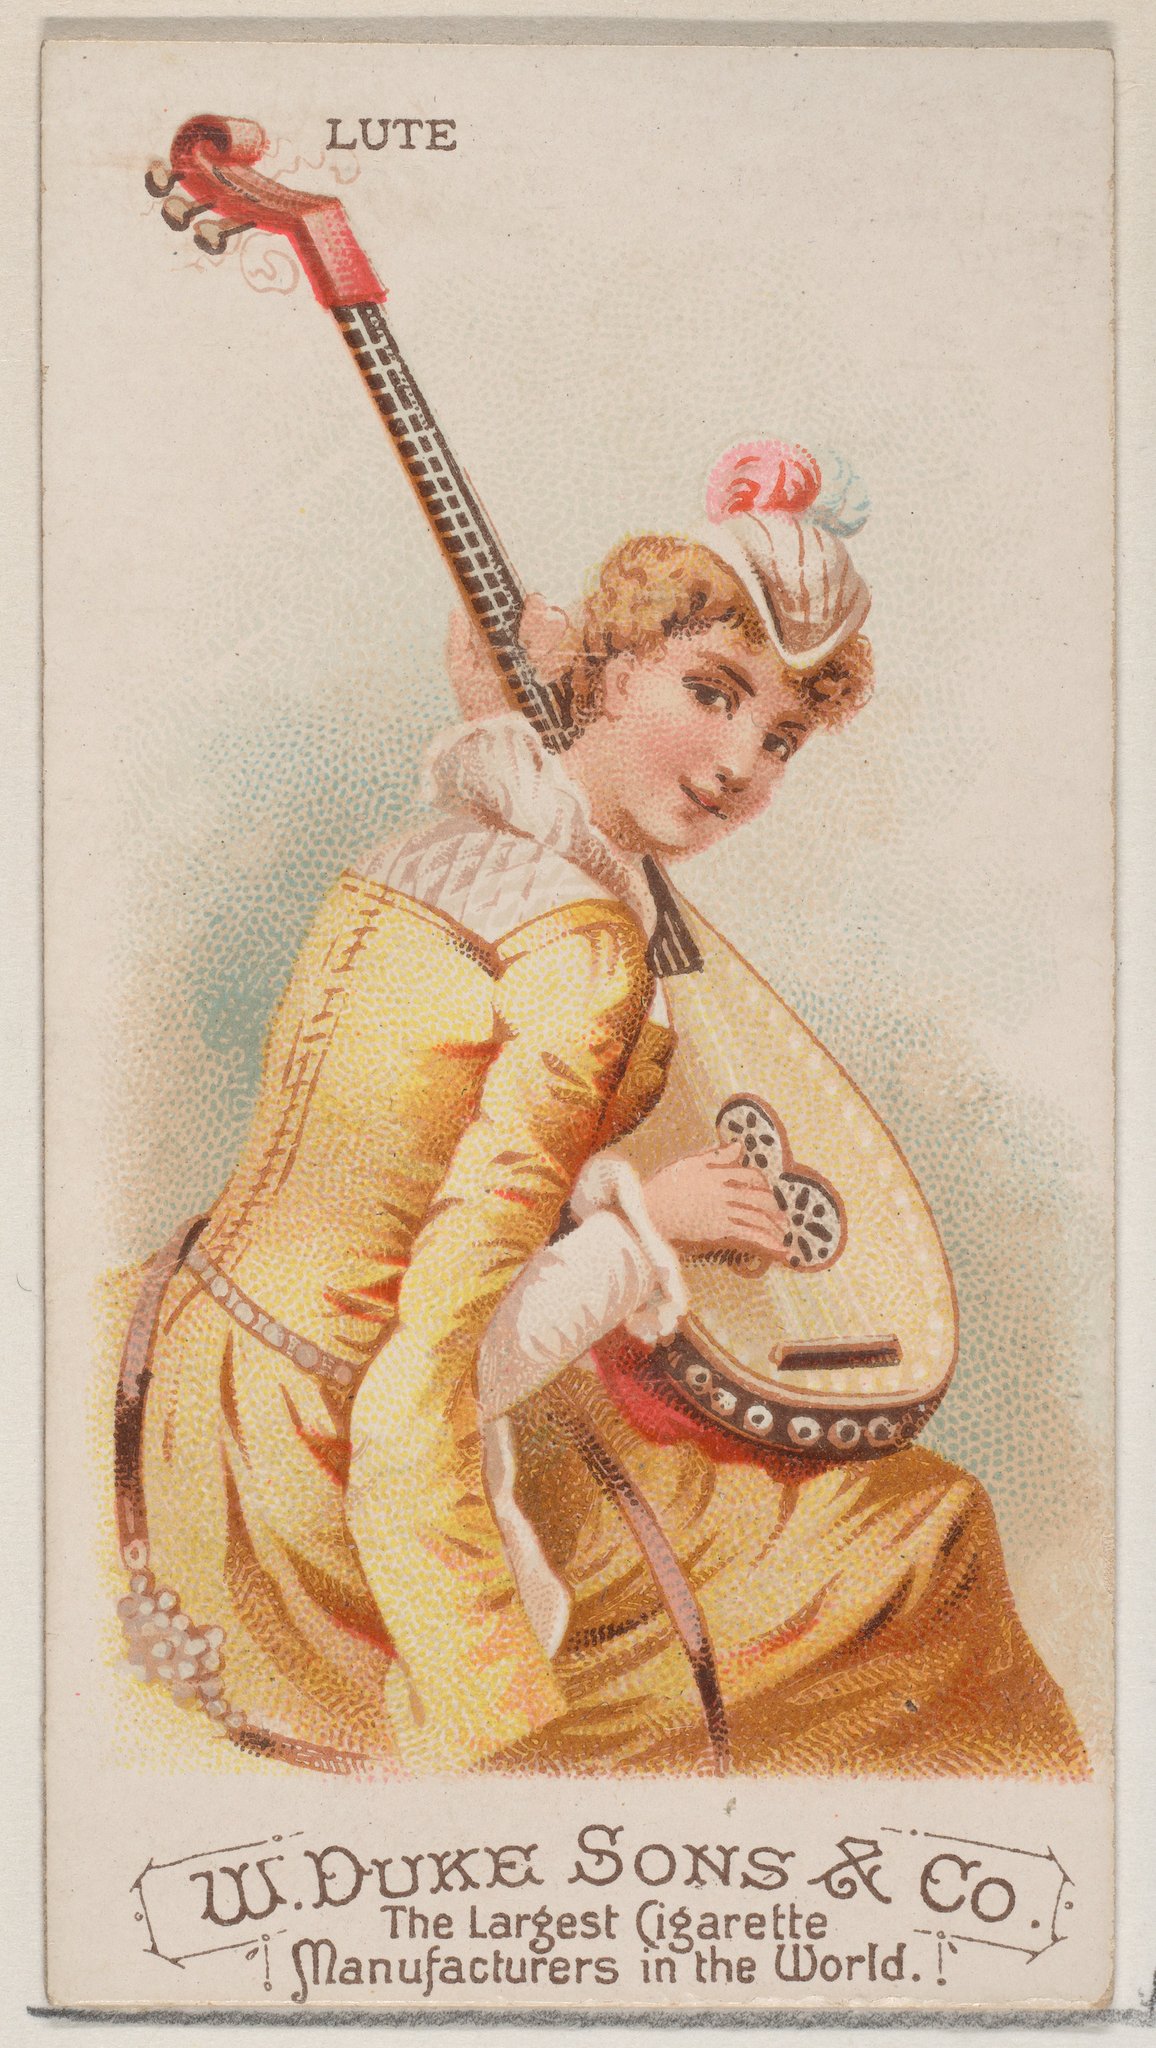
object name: print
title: Lute, from the Musical Instruments series (N82) for Duke brand cigarettes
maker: w. duke, sons & co.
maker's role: publisher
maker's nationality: american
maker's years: 1870-1920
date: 1888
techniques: color lithograph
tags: women,lutes,musicians